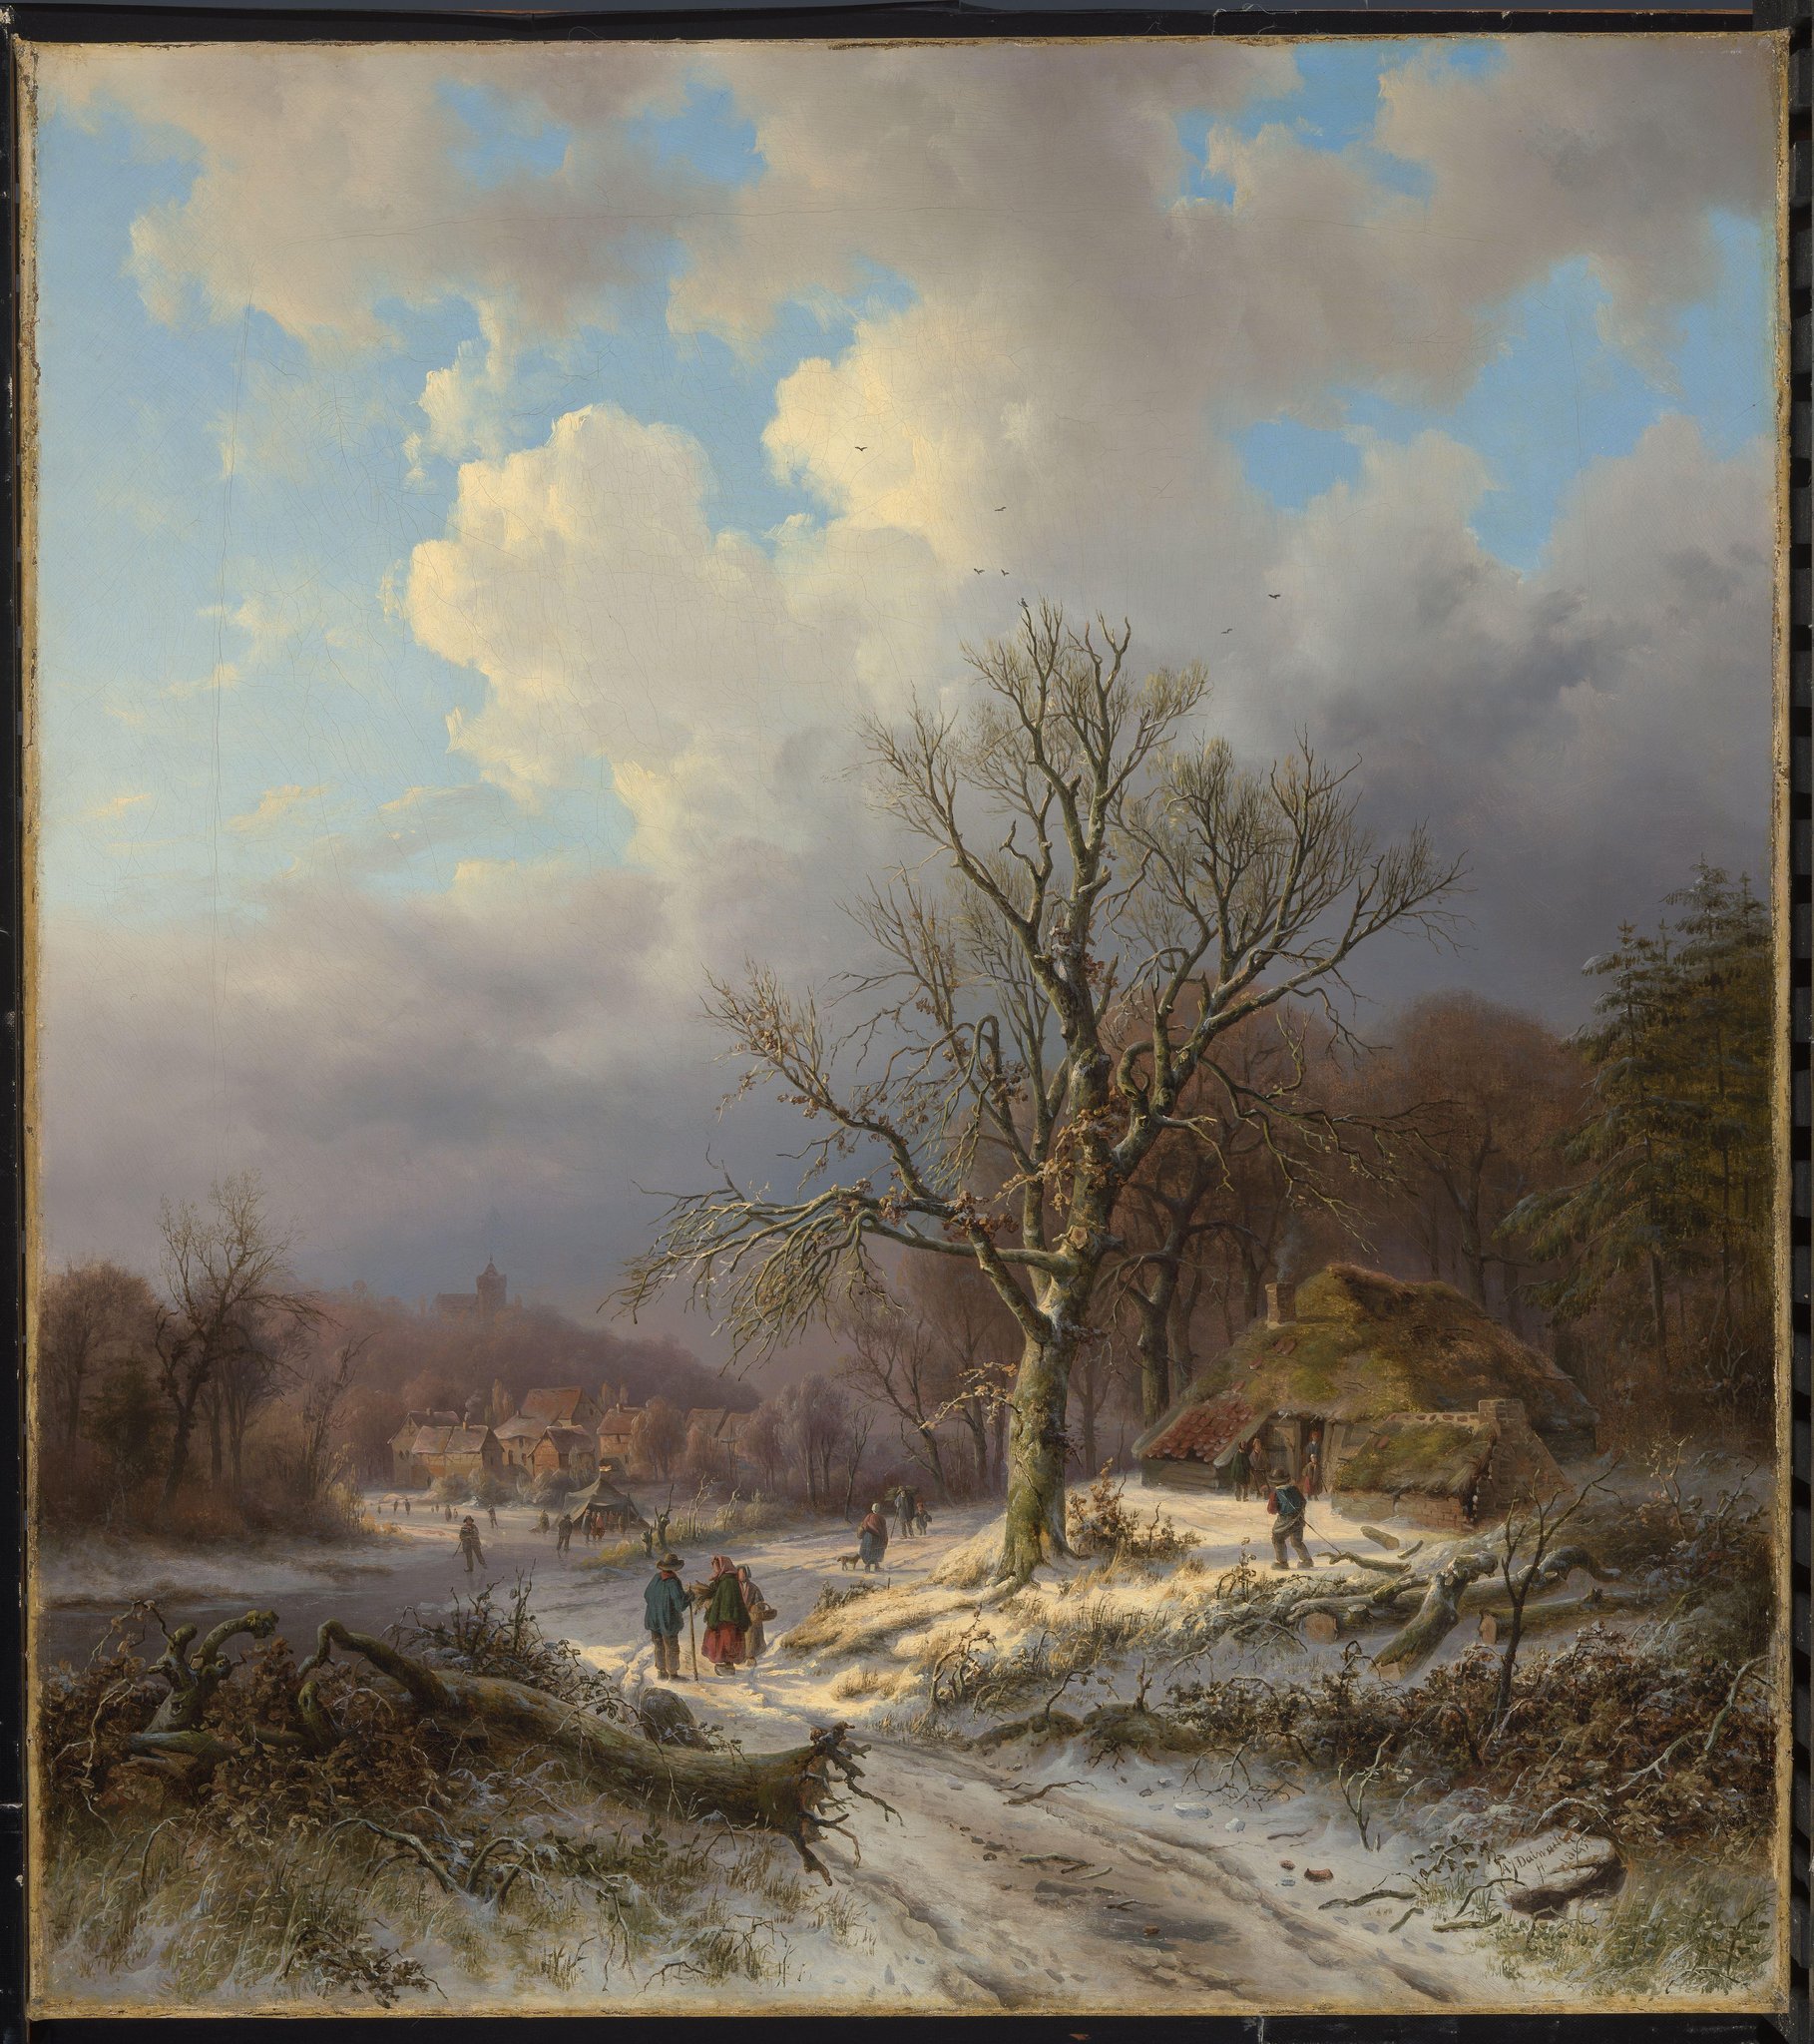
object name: painting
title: Snow Landscape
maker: alexander joseph daiwaille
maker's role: print maker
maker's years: 1818-1888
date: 1845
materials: canvas, oil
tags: forest, wood, winter landscape; landscape symbolizing winter (the four seasons of the year), snow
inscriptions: signature and date: ‘A.J. Daiwaille ft. 1845’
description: Sneeuwlandschap. Verschillende figuren en huisjes in een winterlandschap.